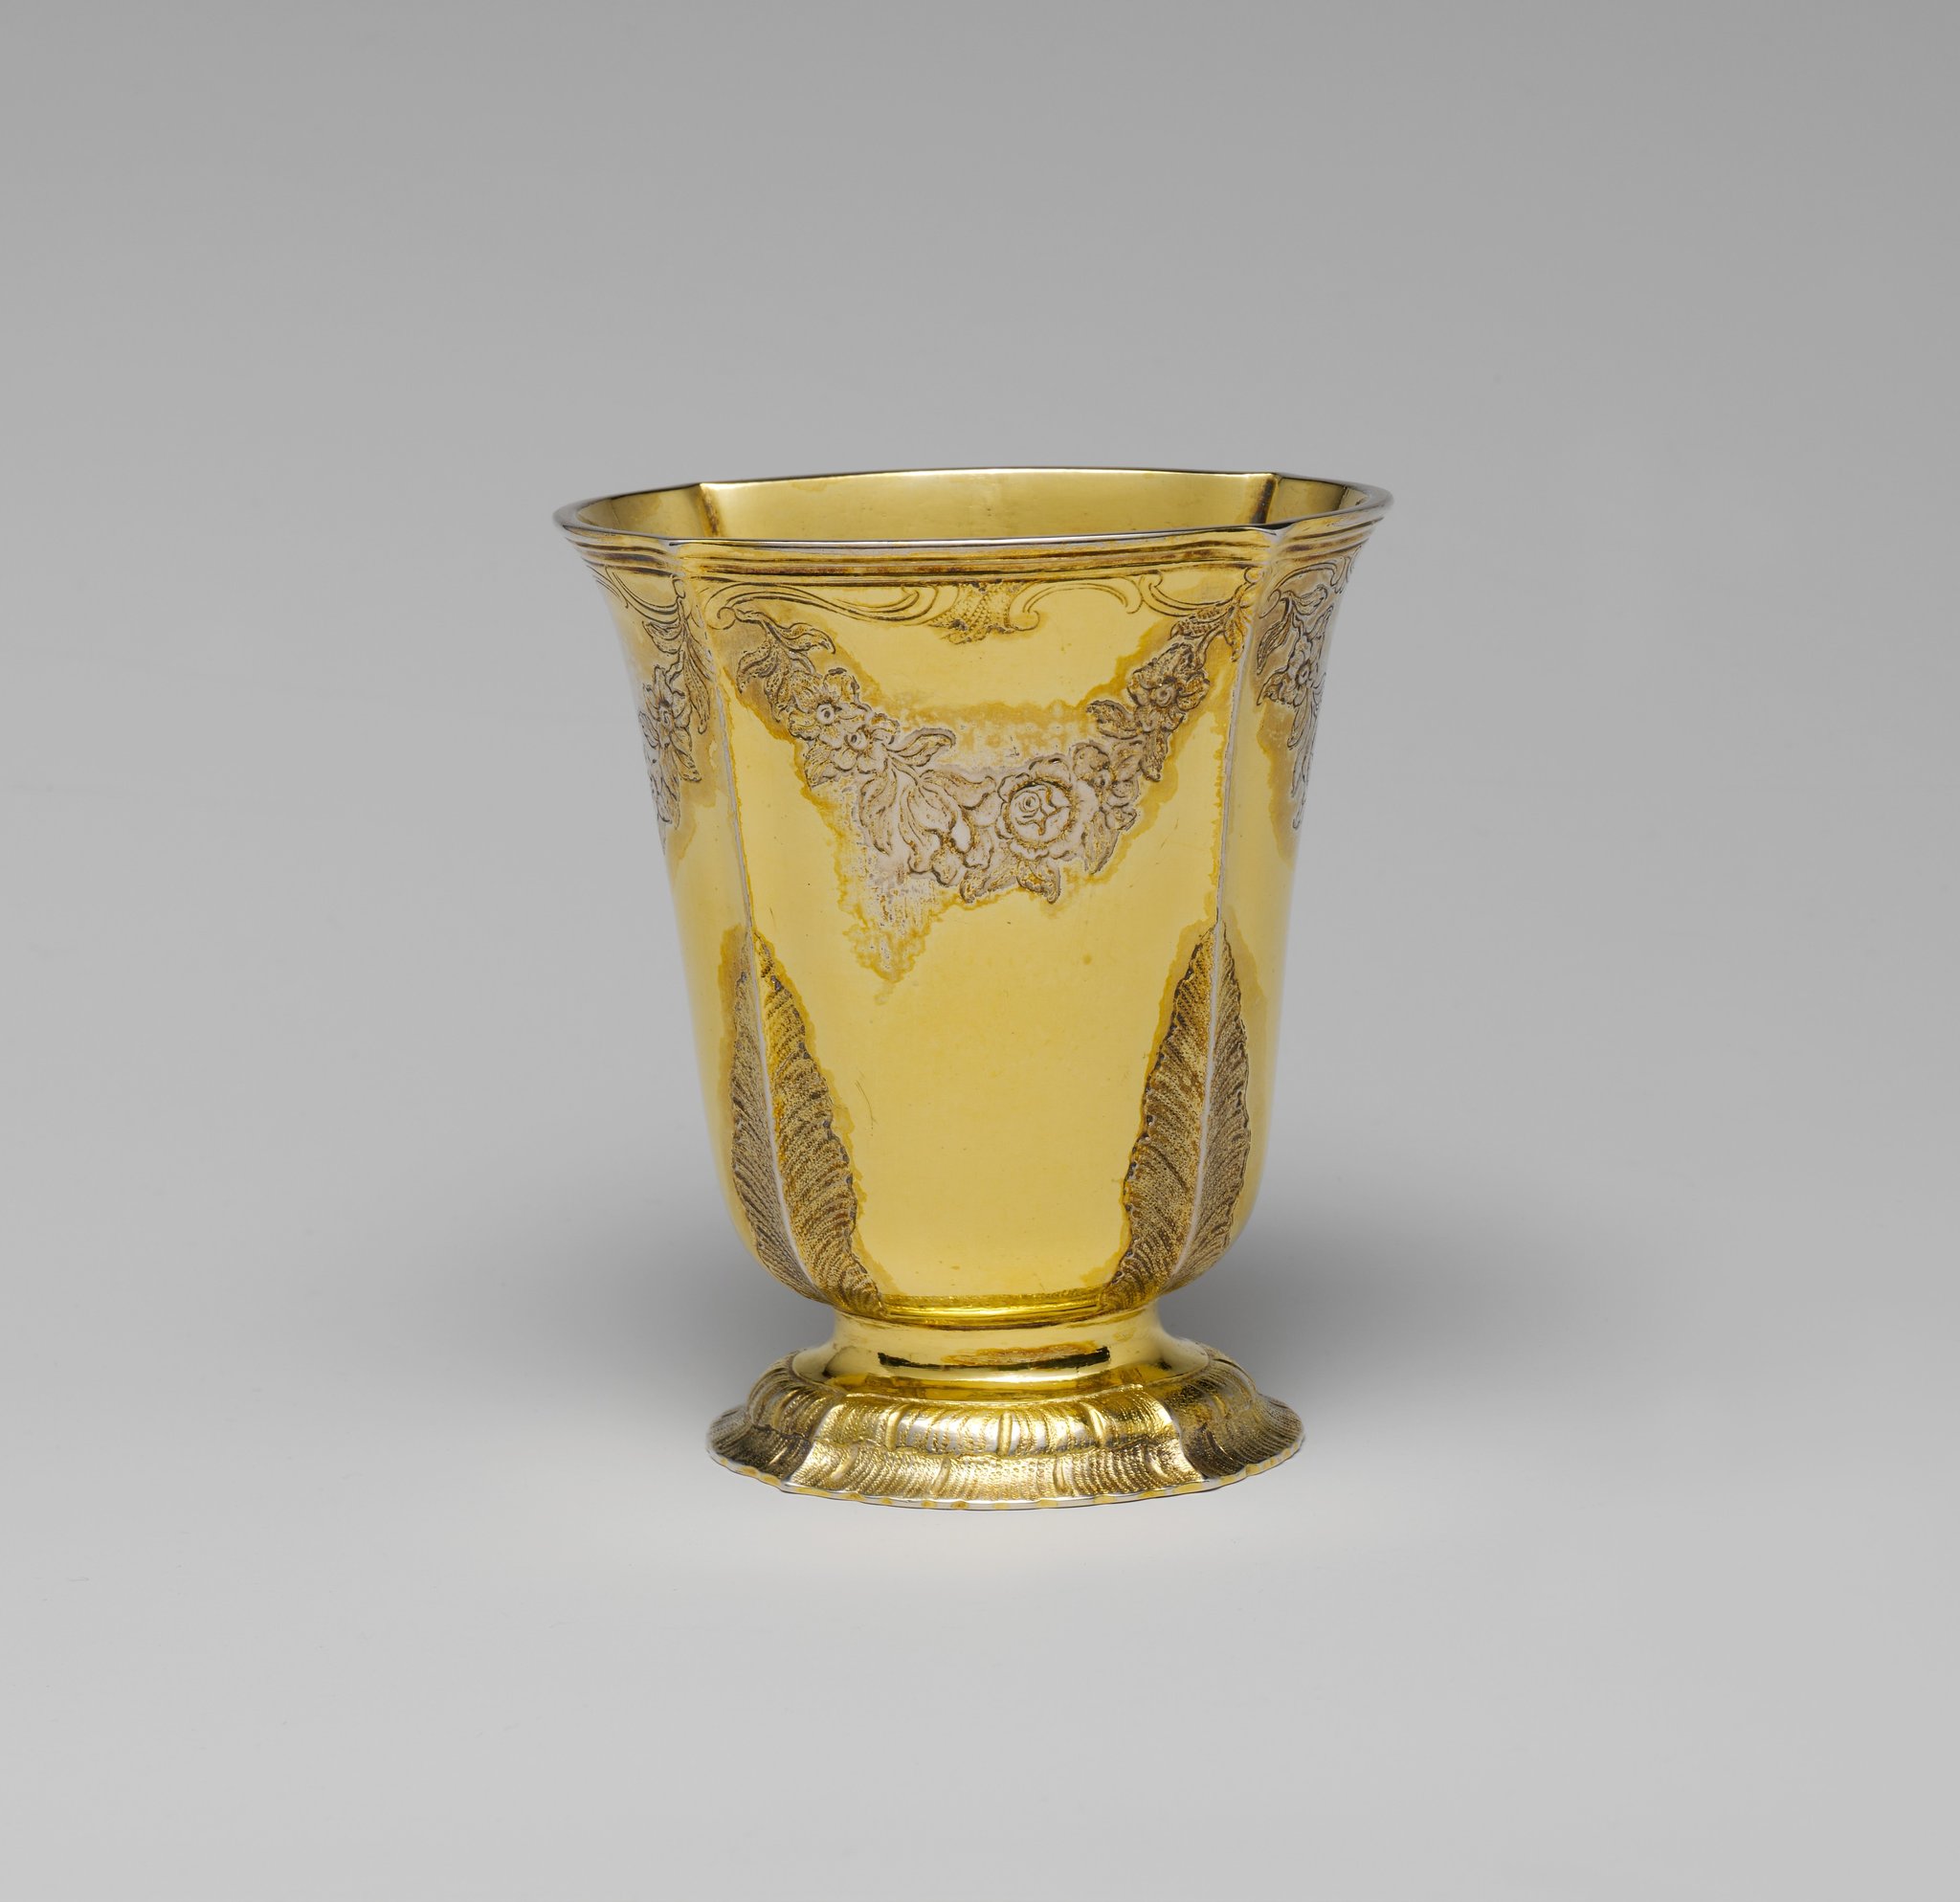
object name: beaker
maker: jean-jacques kirstein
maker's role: maker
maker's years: 1760-1798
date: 1770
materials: silver gilt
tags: garlands